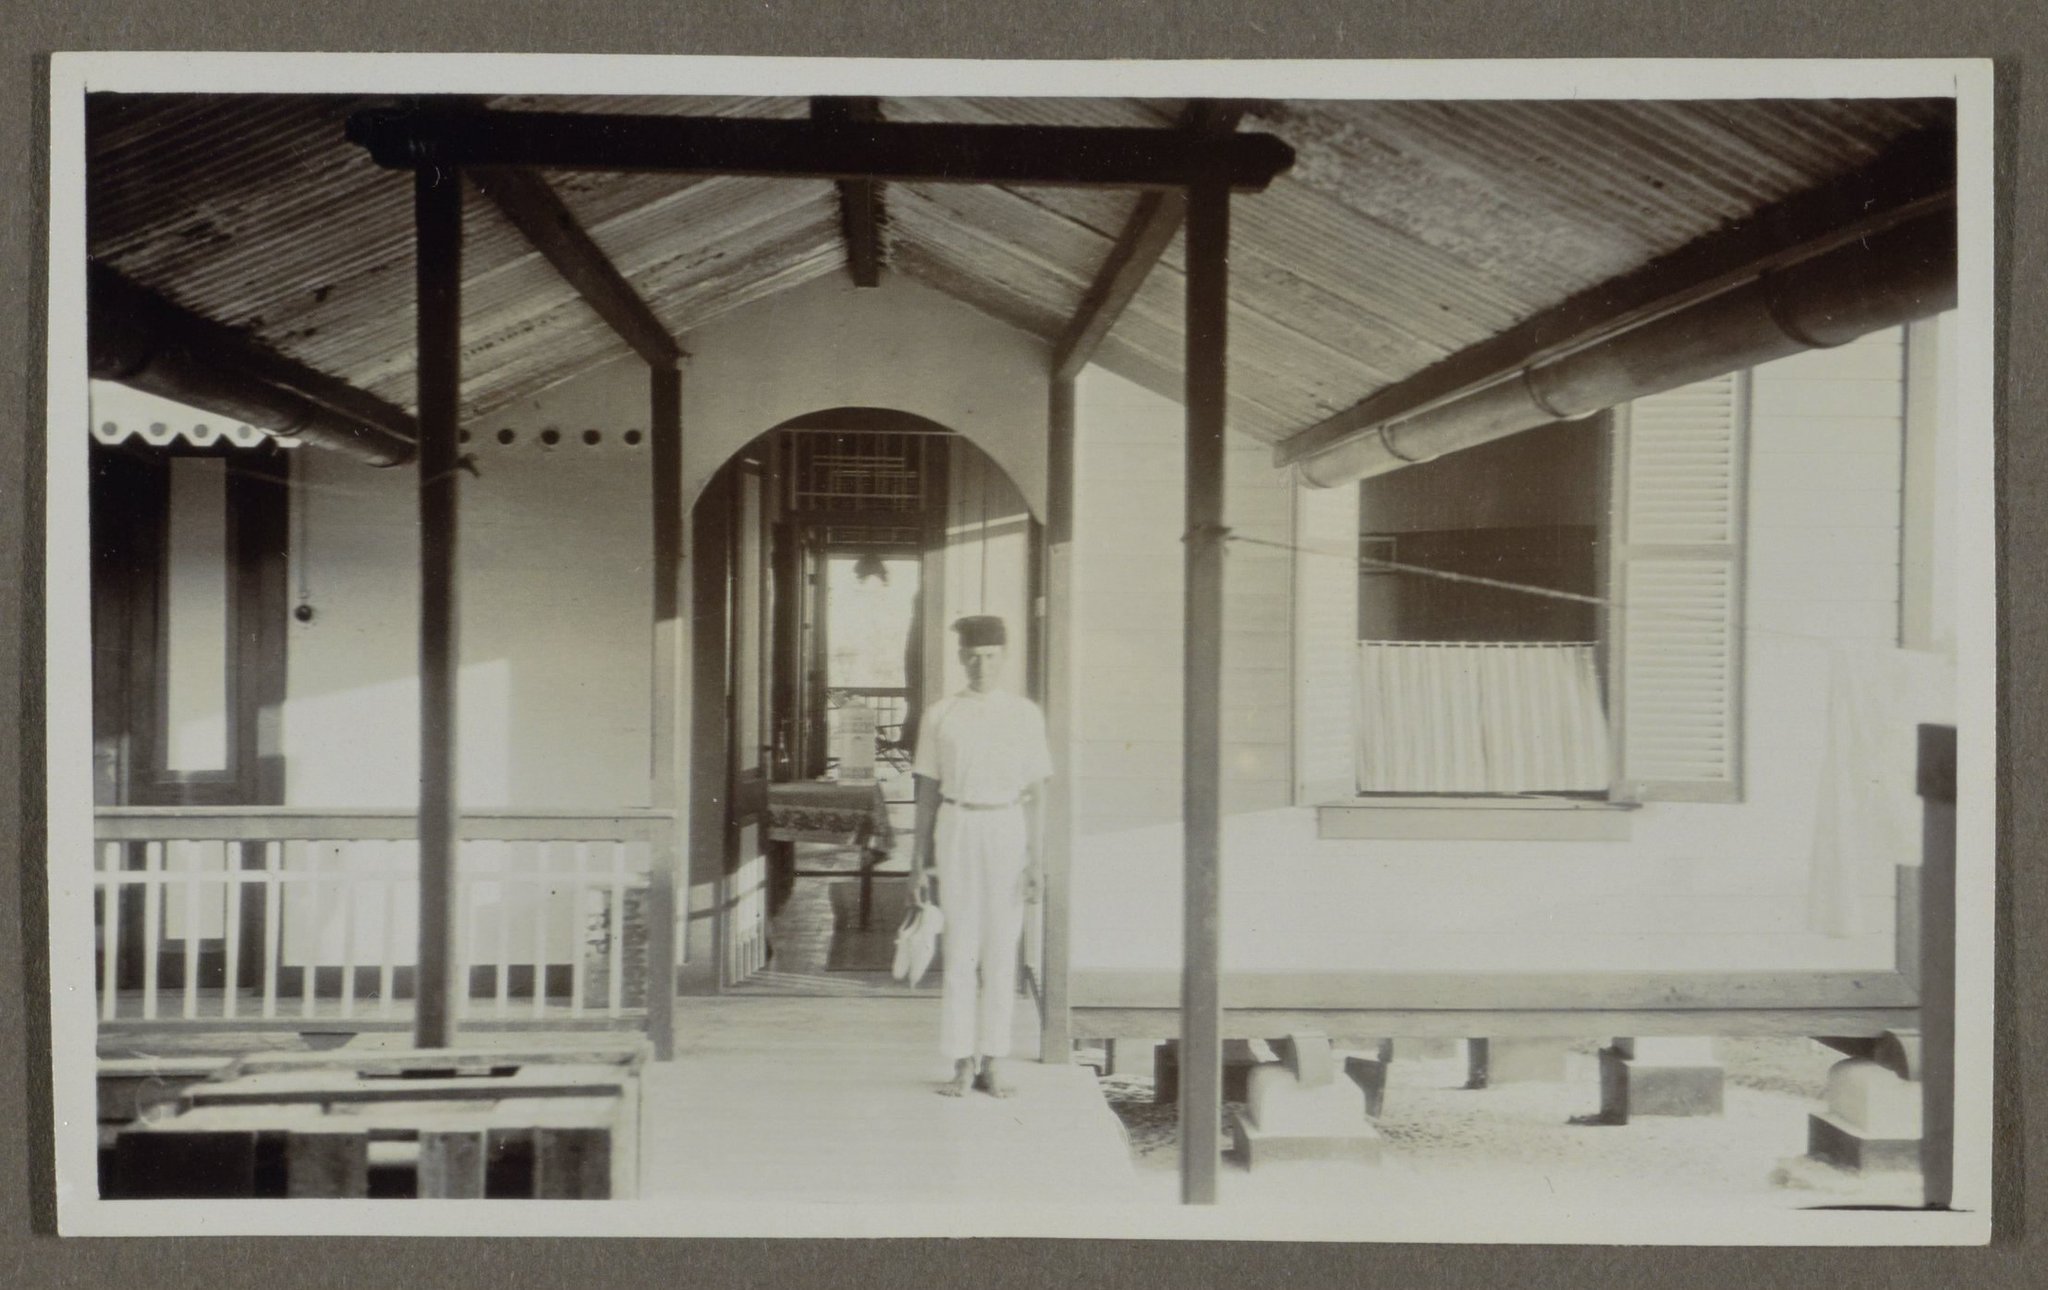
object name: photograph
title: Indische man staand voor een deuropening in overdekte ruimte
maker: Anonymous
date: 1920-1930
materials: photographic support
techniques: gelatin silver print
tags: sun-porch, sun-parlour, glazed verandah, dutch east indies, the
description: Een Indische man staat voor een houten huis, mogelijk op een veranda. Hij is blootsvoets en draagt een hoofddeksel. Hij draagt zijn schoenen in zijn hand. Het huis staat los van de grond. Onderdeel van familiealbum Nederlands-Indië.